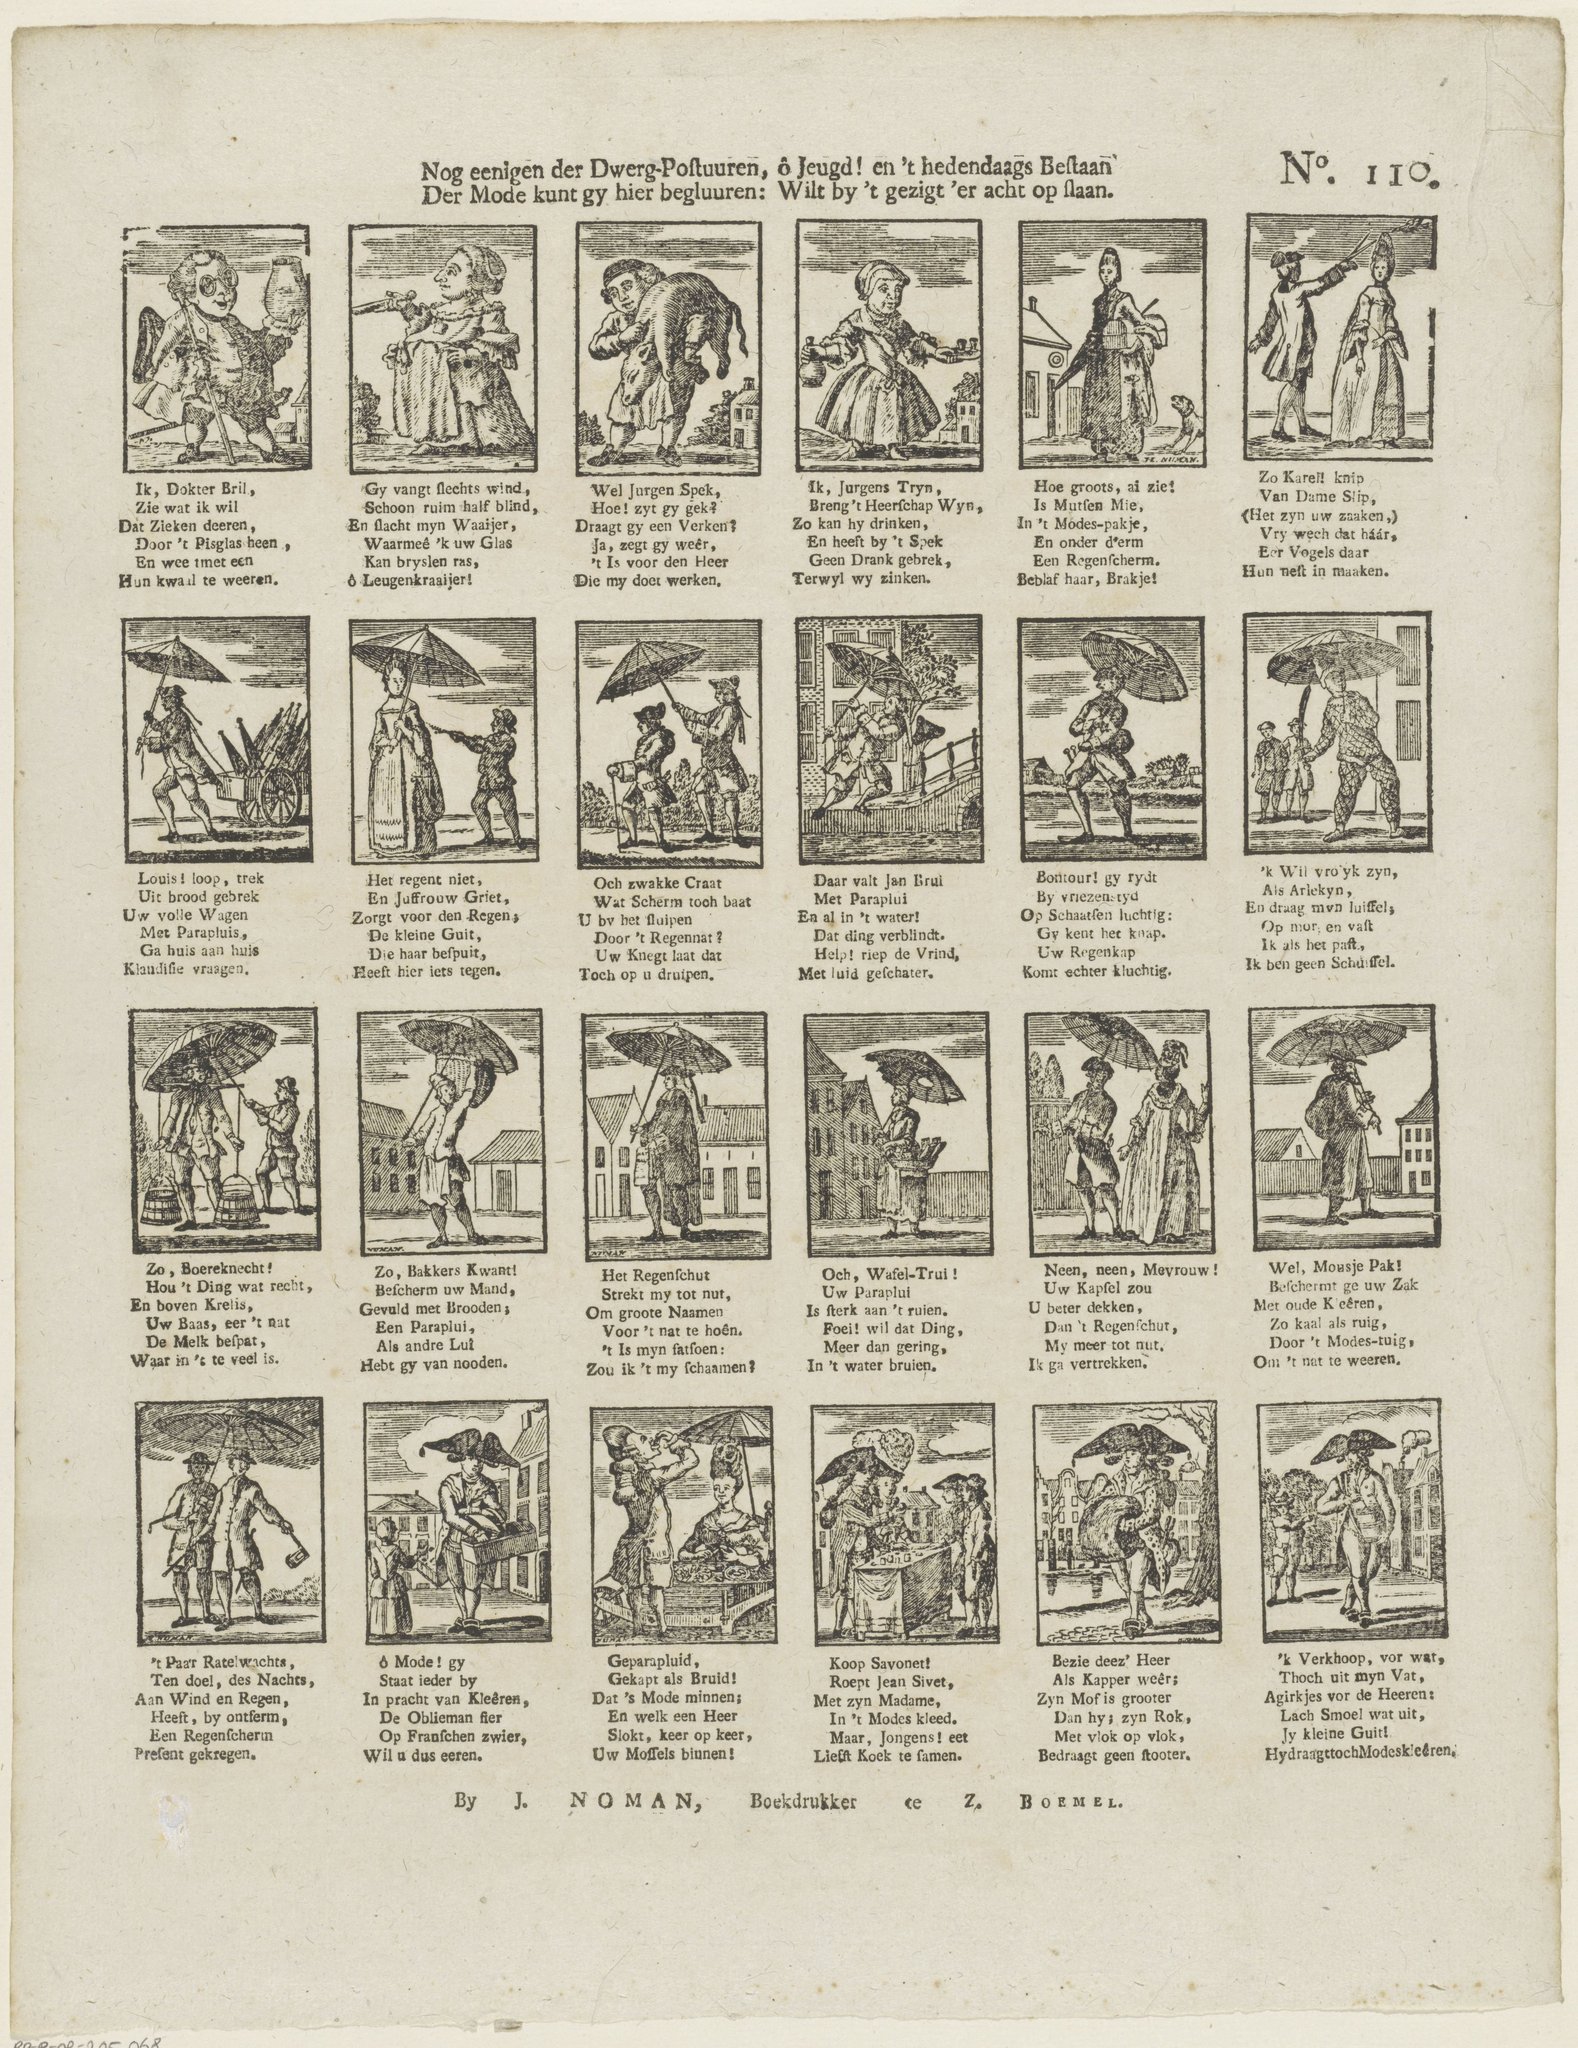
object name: print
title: Nog eenigen der dwerg-posturen, ô jeugd! en 't hedendaags bestaan / Der mode kunt gy hier begluren: Wilt by 't gezigt 'er acht op slaan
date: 1806-1830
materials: paper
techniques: letterpress printing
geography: netherlands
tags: fashion, clothing, caricatures (human types), fashion, comedy, parasol, sunshade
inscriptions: collector's mark: Lugt 2760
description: Spotprent op de mode met 24 voorstellingen van een mannen, vrouwen en karikaturele figuren met parasollen. Onder elke afbeelding een zesregelig vers. Genummerd rechtsboven: No. 110.